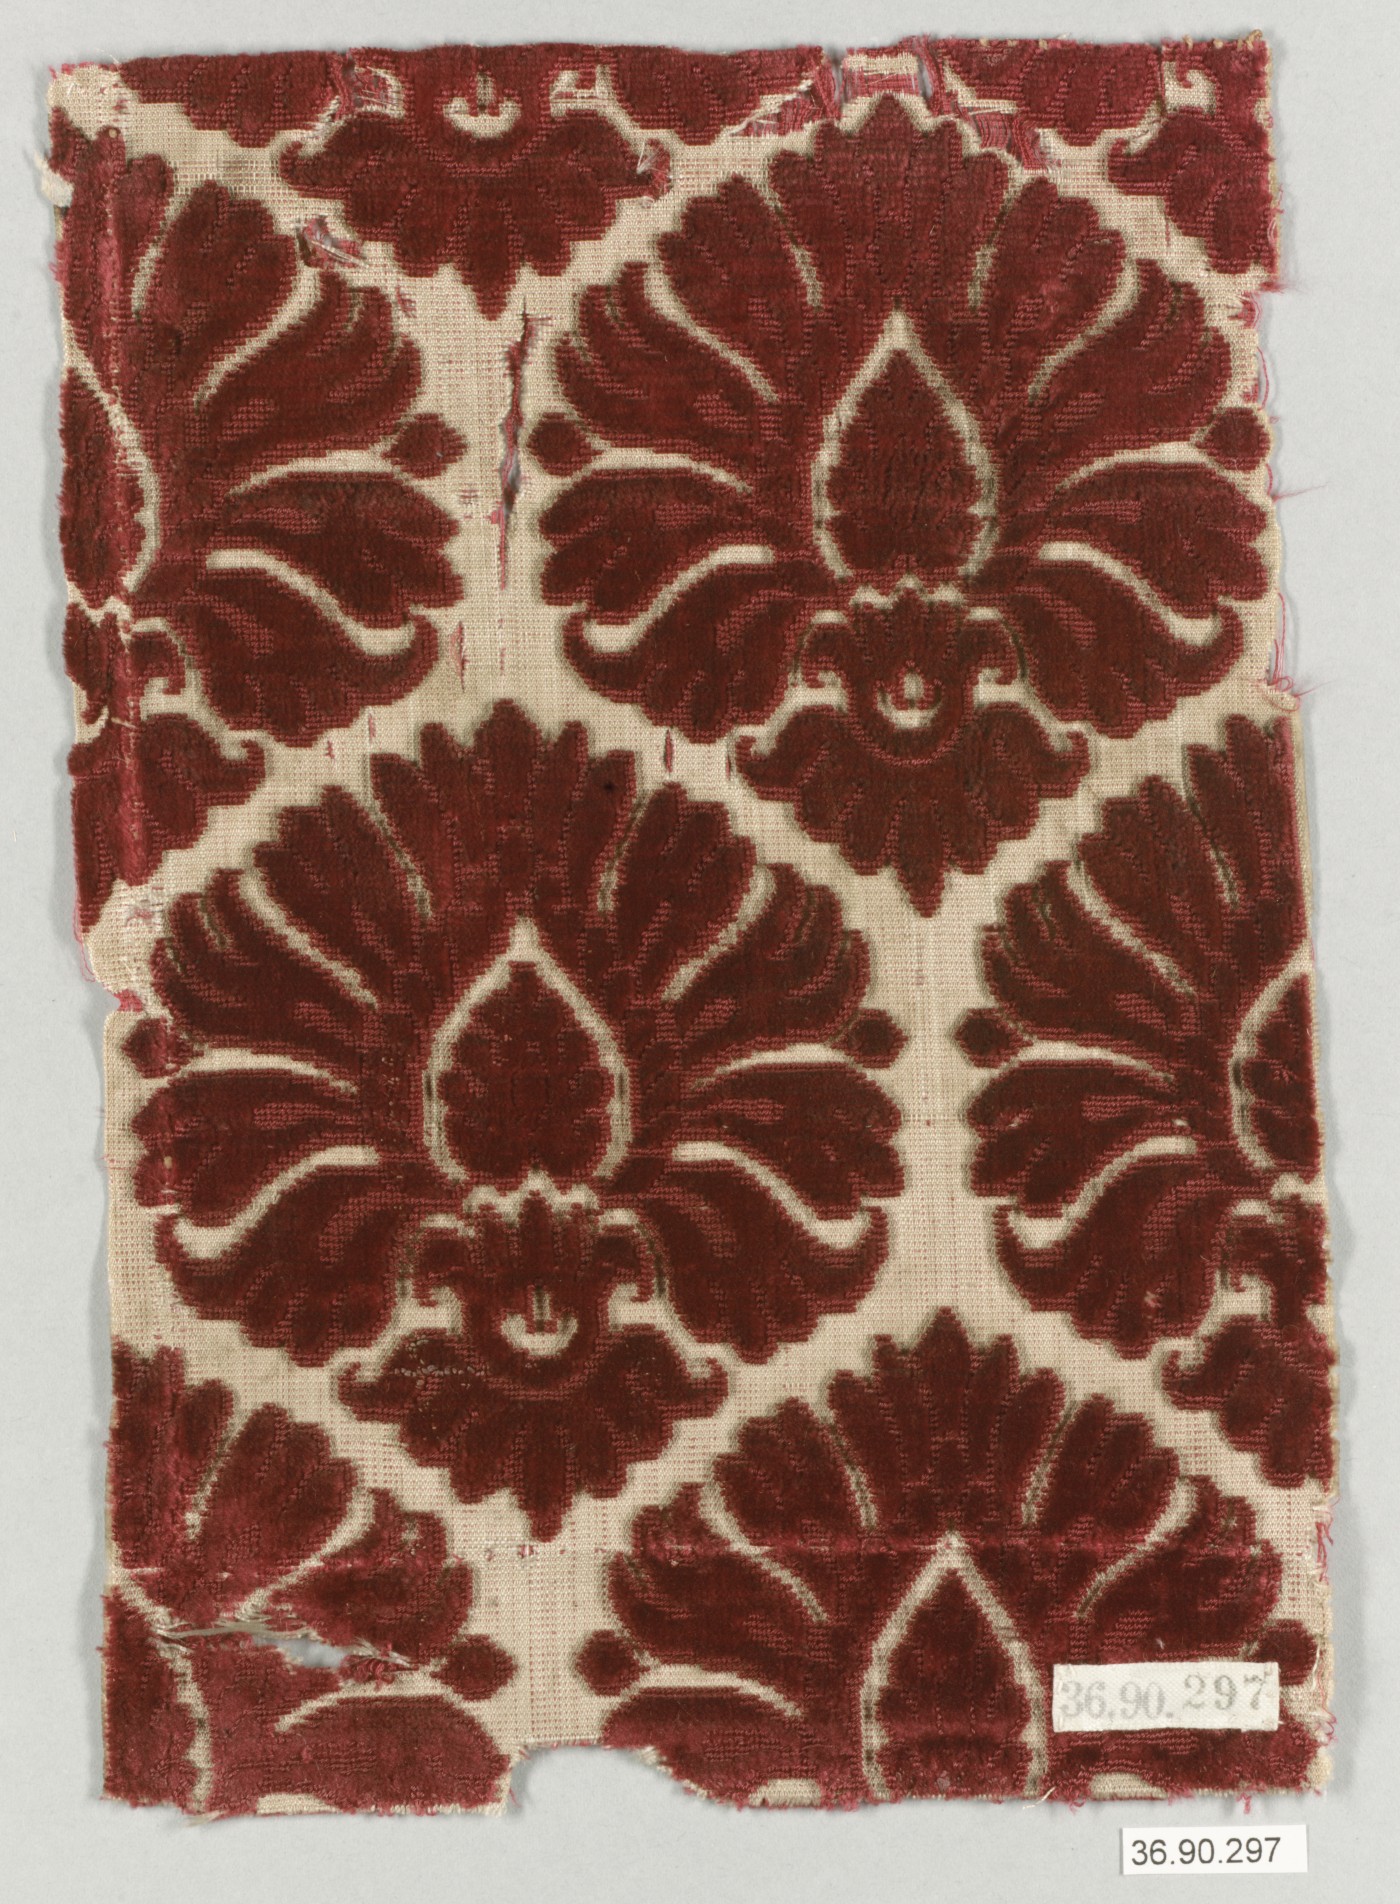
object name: piece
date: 1501-1700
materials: silk